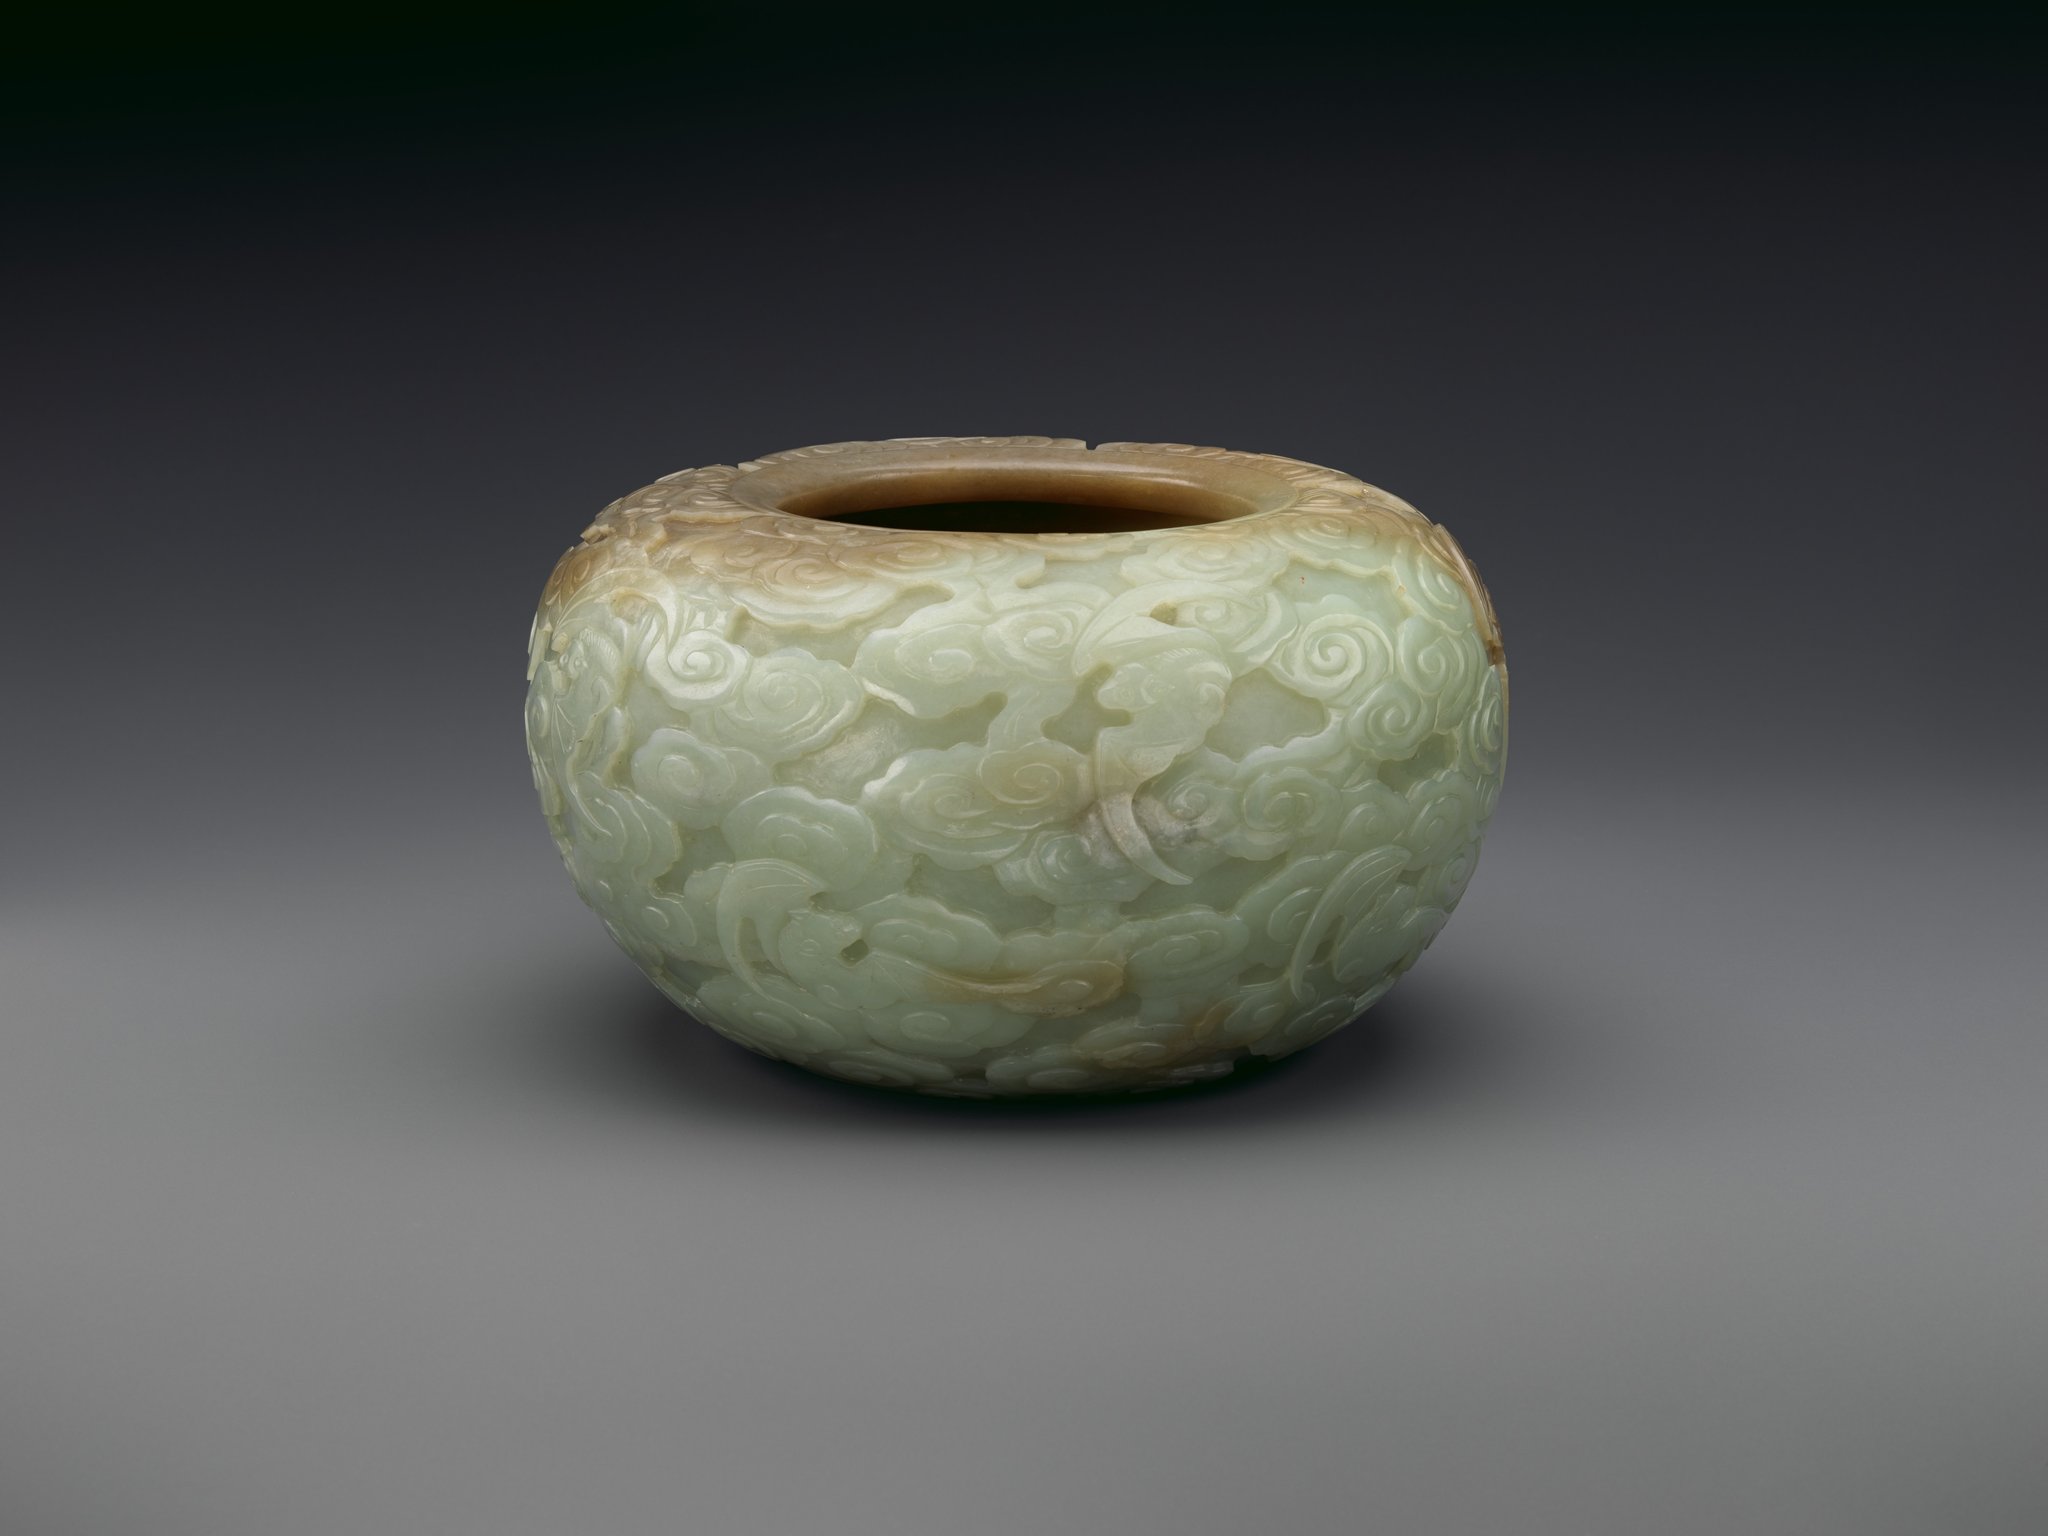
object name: bowl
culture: chinese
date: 1767-1833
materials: jade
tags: bats